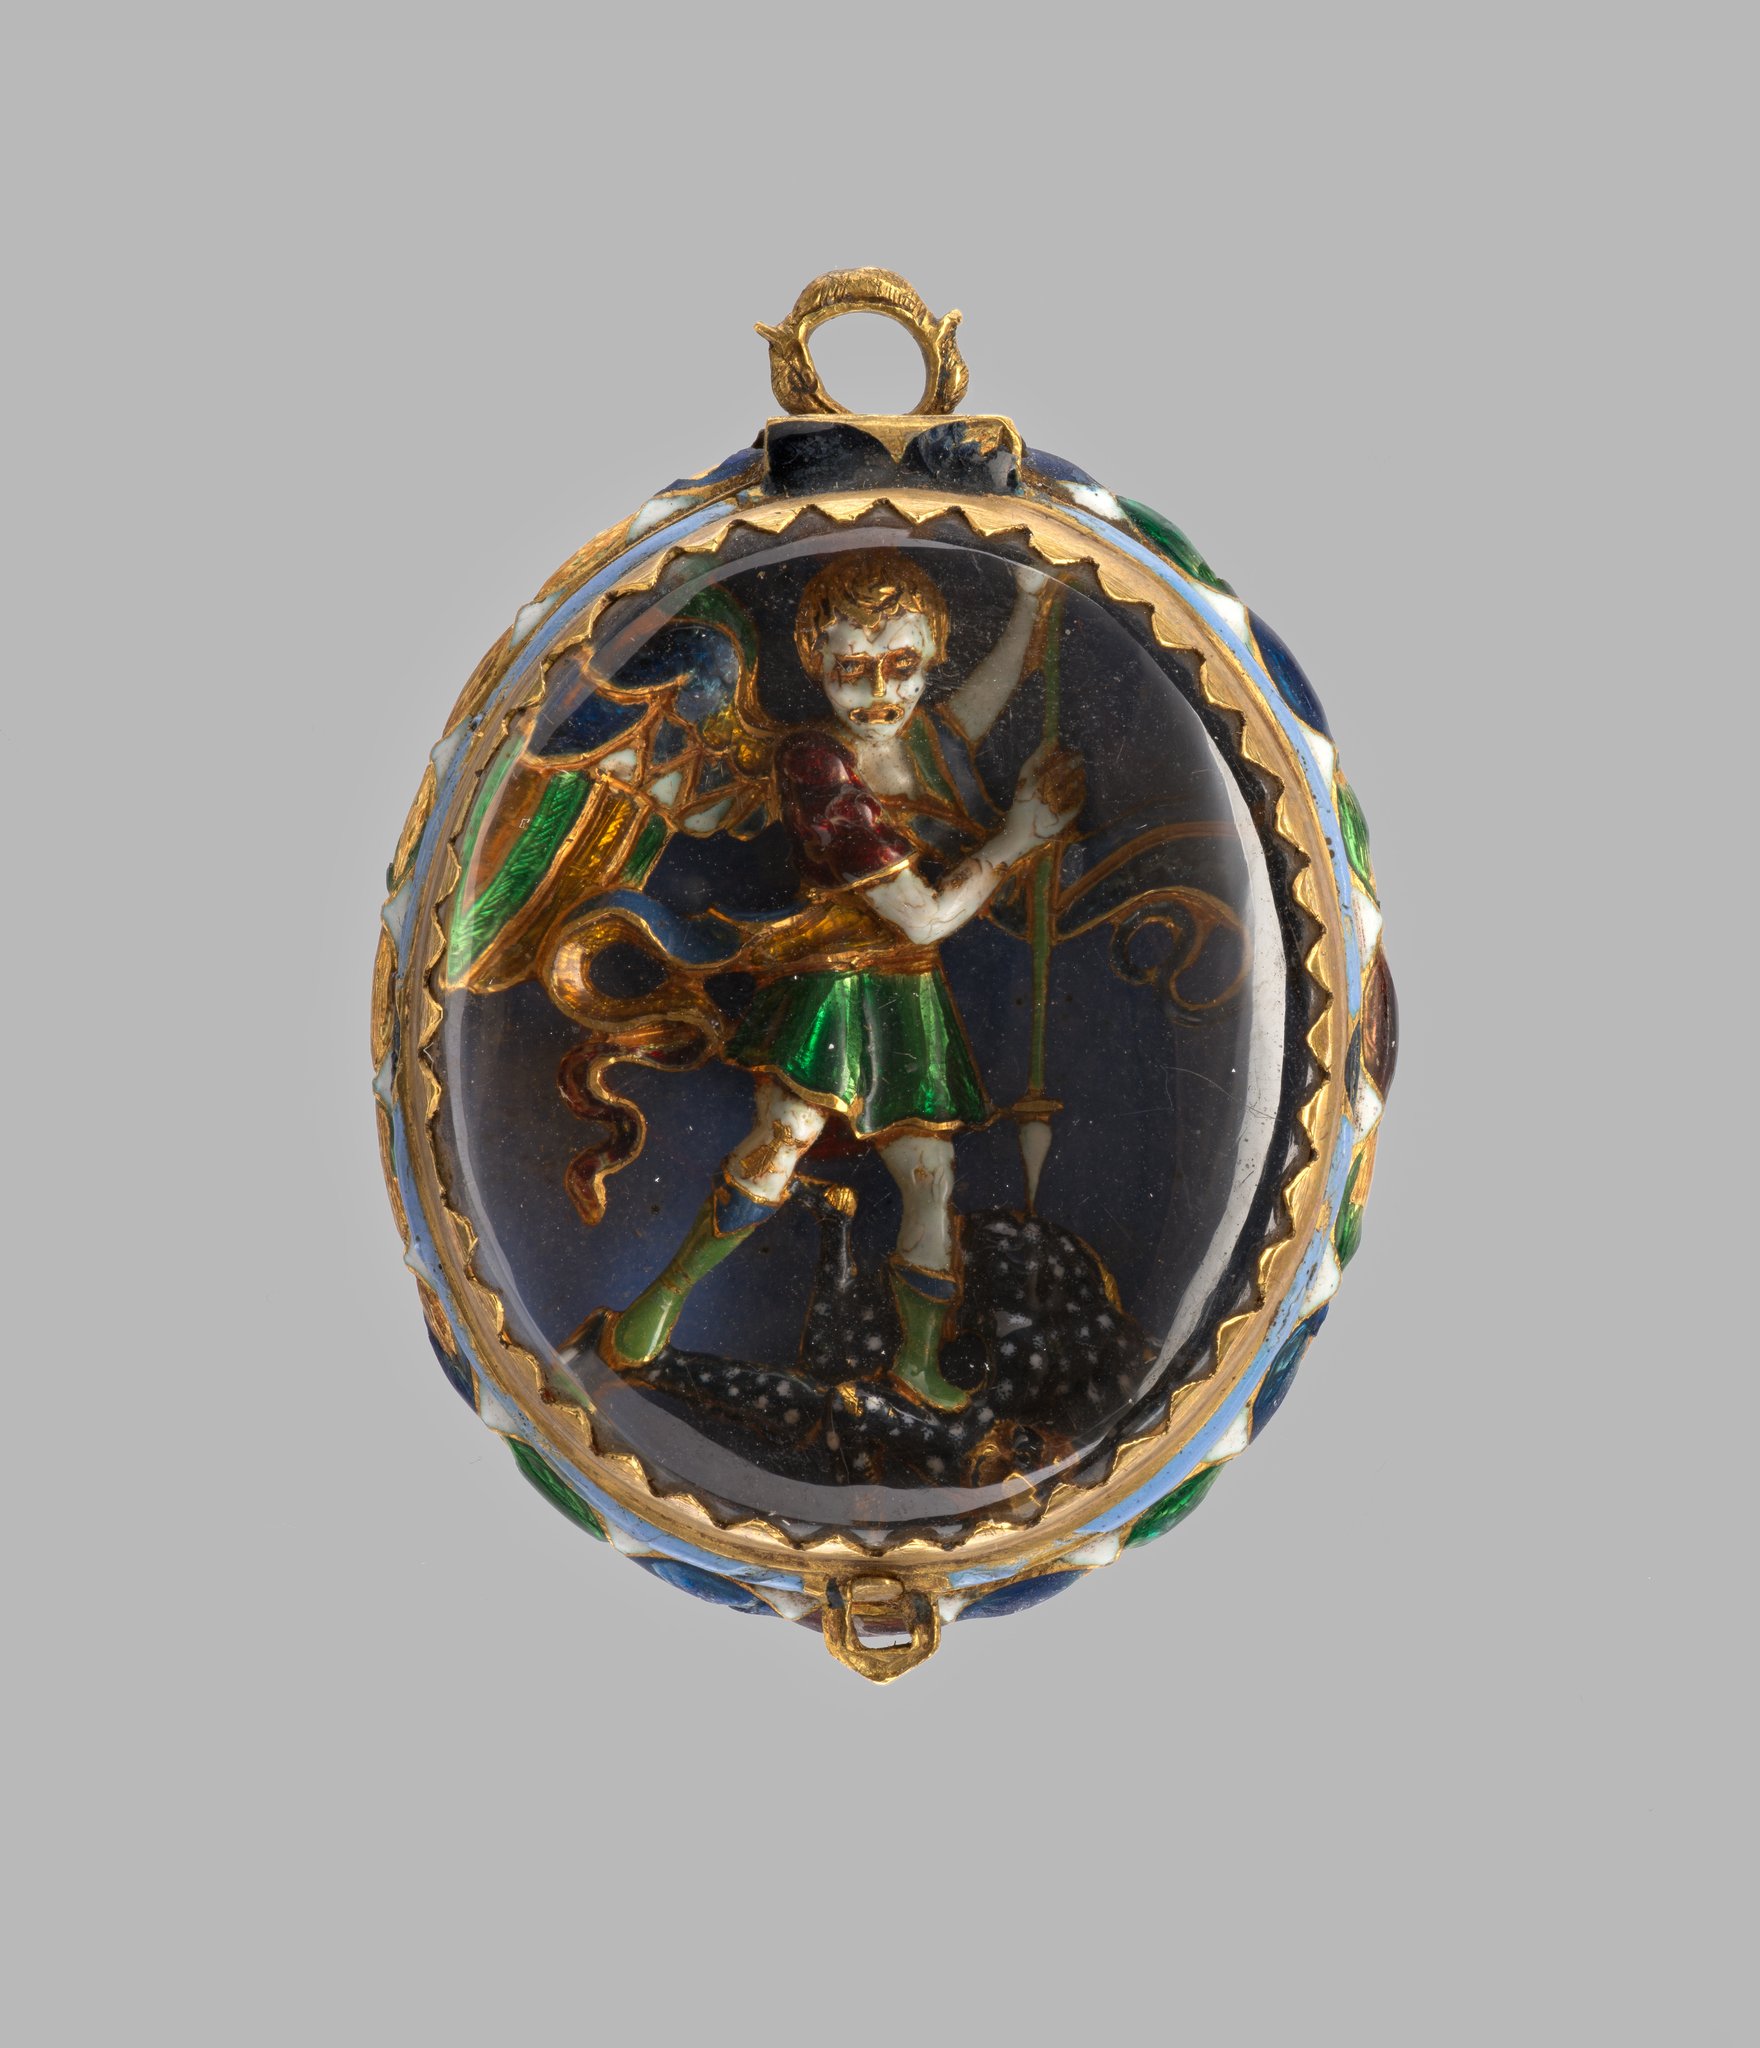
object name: locket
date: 1620-1640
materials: gold, quartz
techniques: enamel